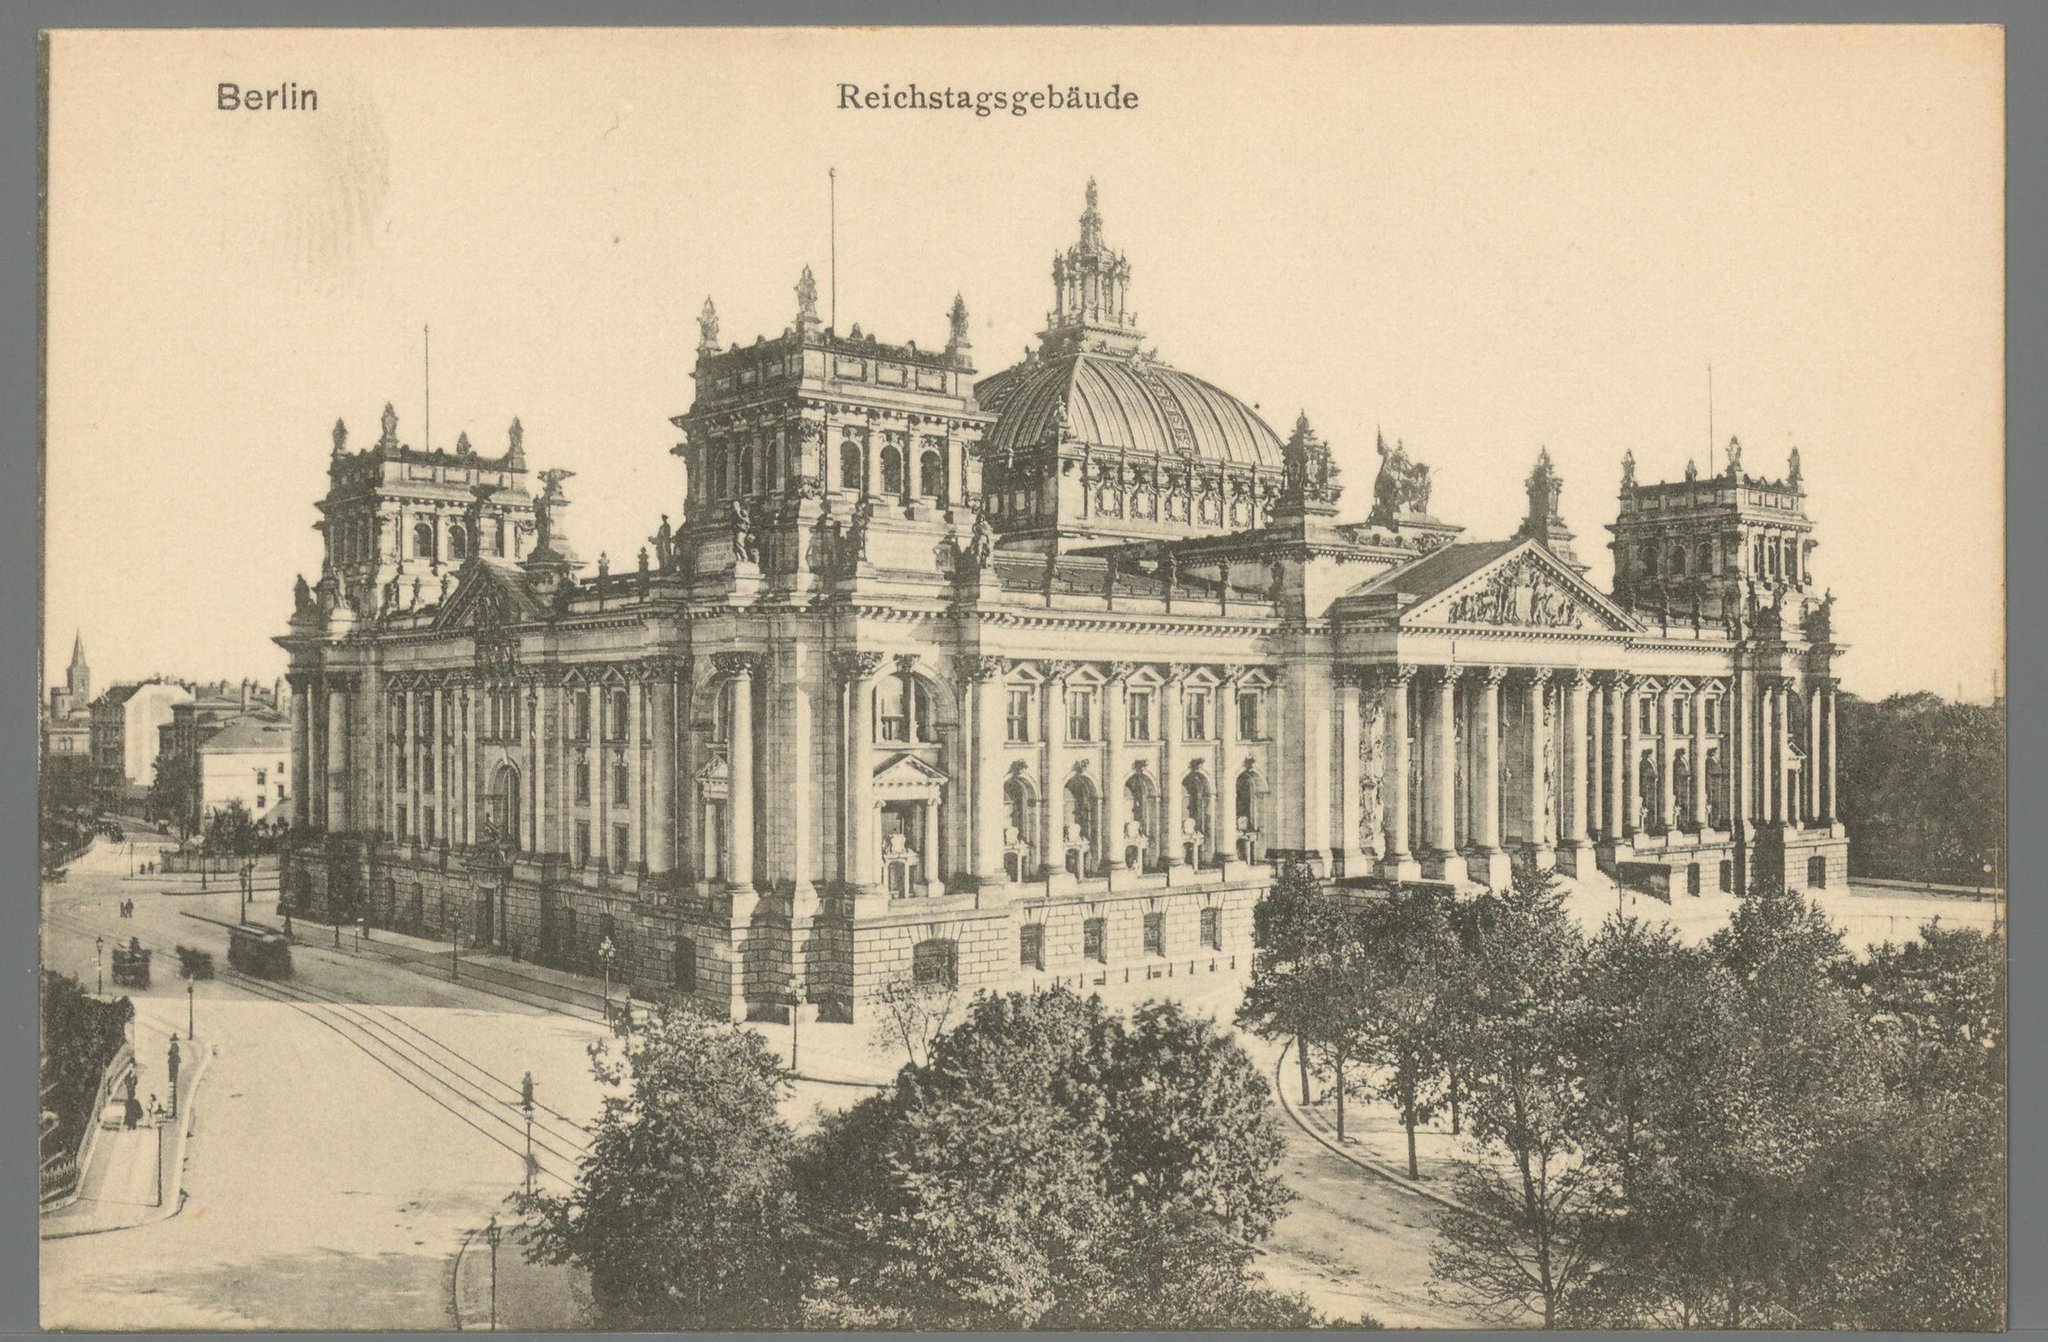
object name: photomechanical print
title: Dom. Reichstagsgebäude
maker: Anonymous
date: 1905-1916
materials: cardboard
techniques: photograph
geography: berlin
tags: city-view, and landscape with man-made constructions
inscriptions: stamp: ‘5’